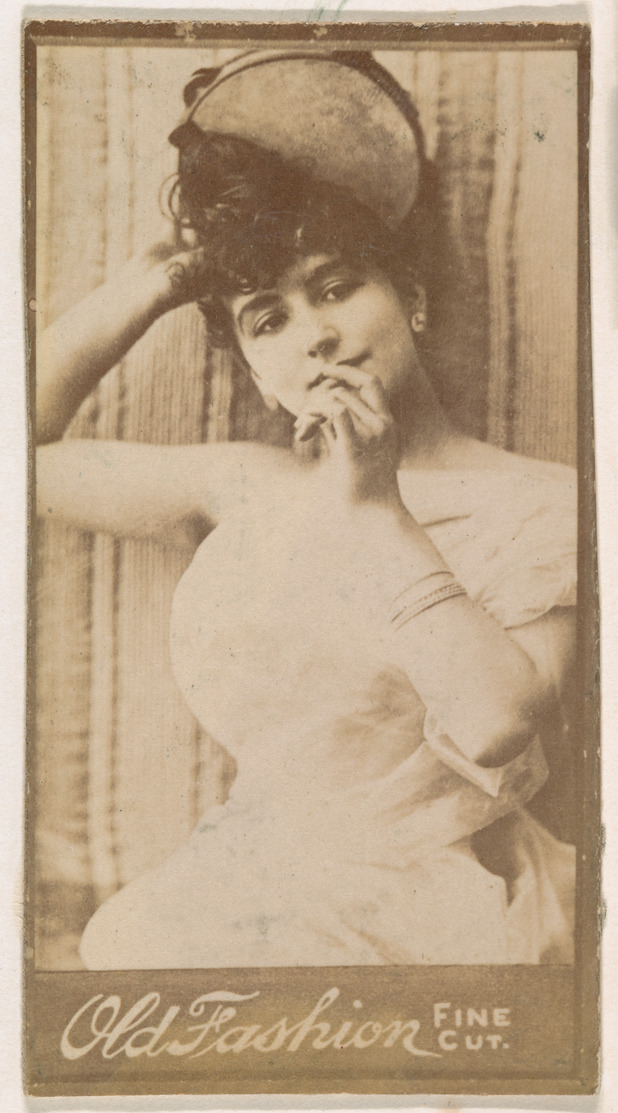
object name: photograph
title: Actress posing with hand to lips, from the Actresses series (N664) promoting Old Fashion Fine Cut Tobacco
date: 1888-1890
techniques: albumen silver print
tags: portraits,women,actresses